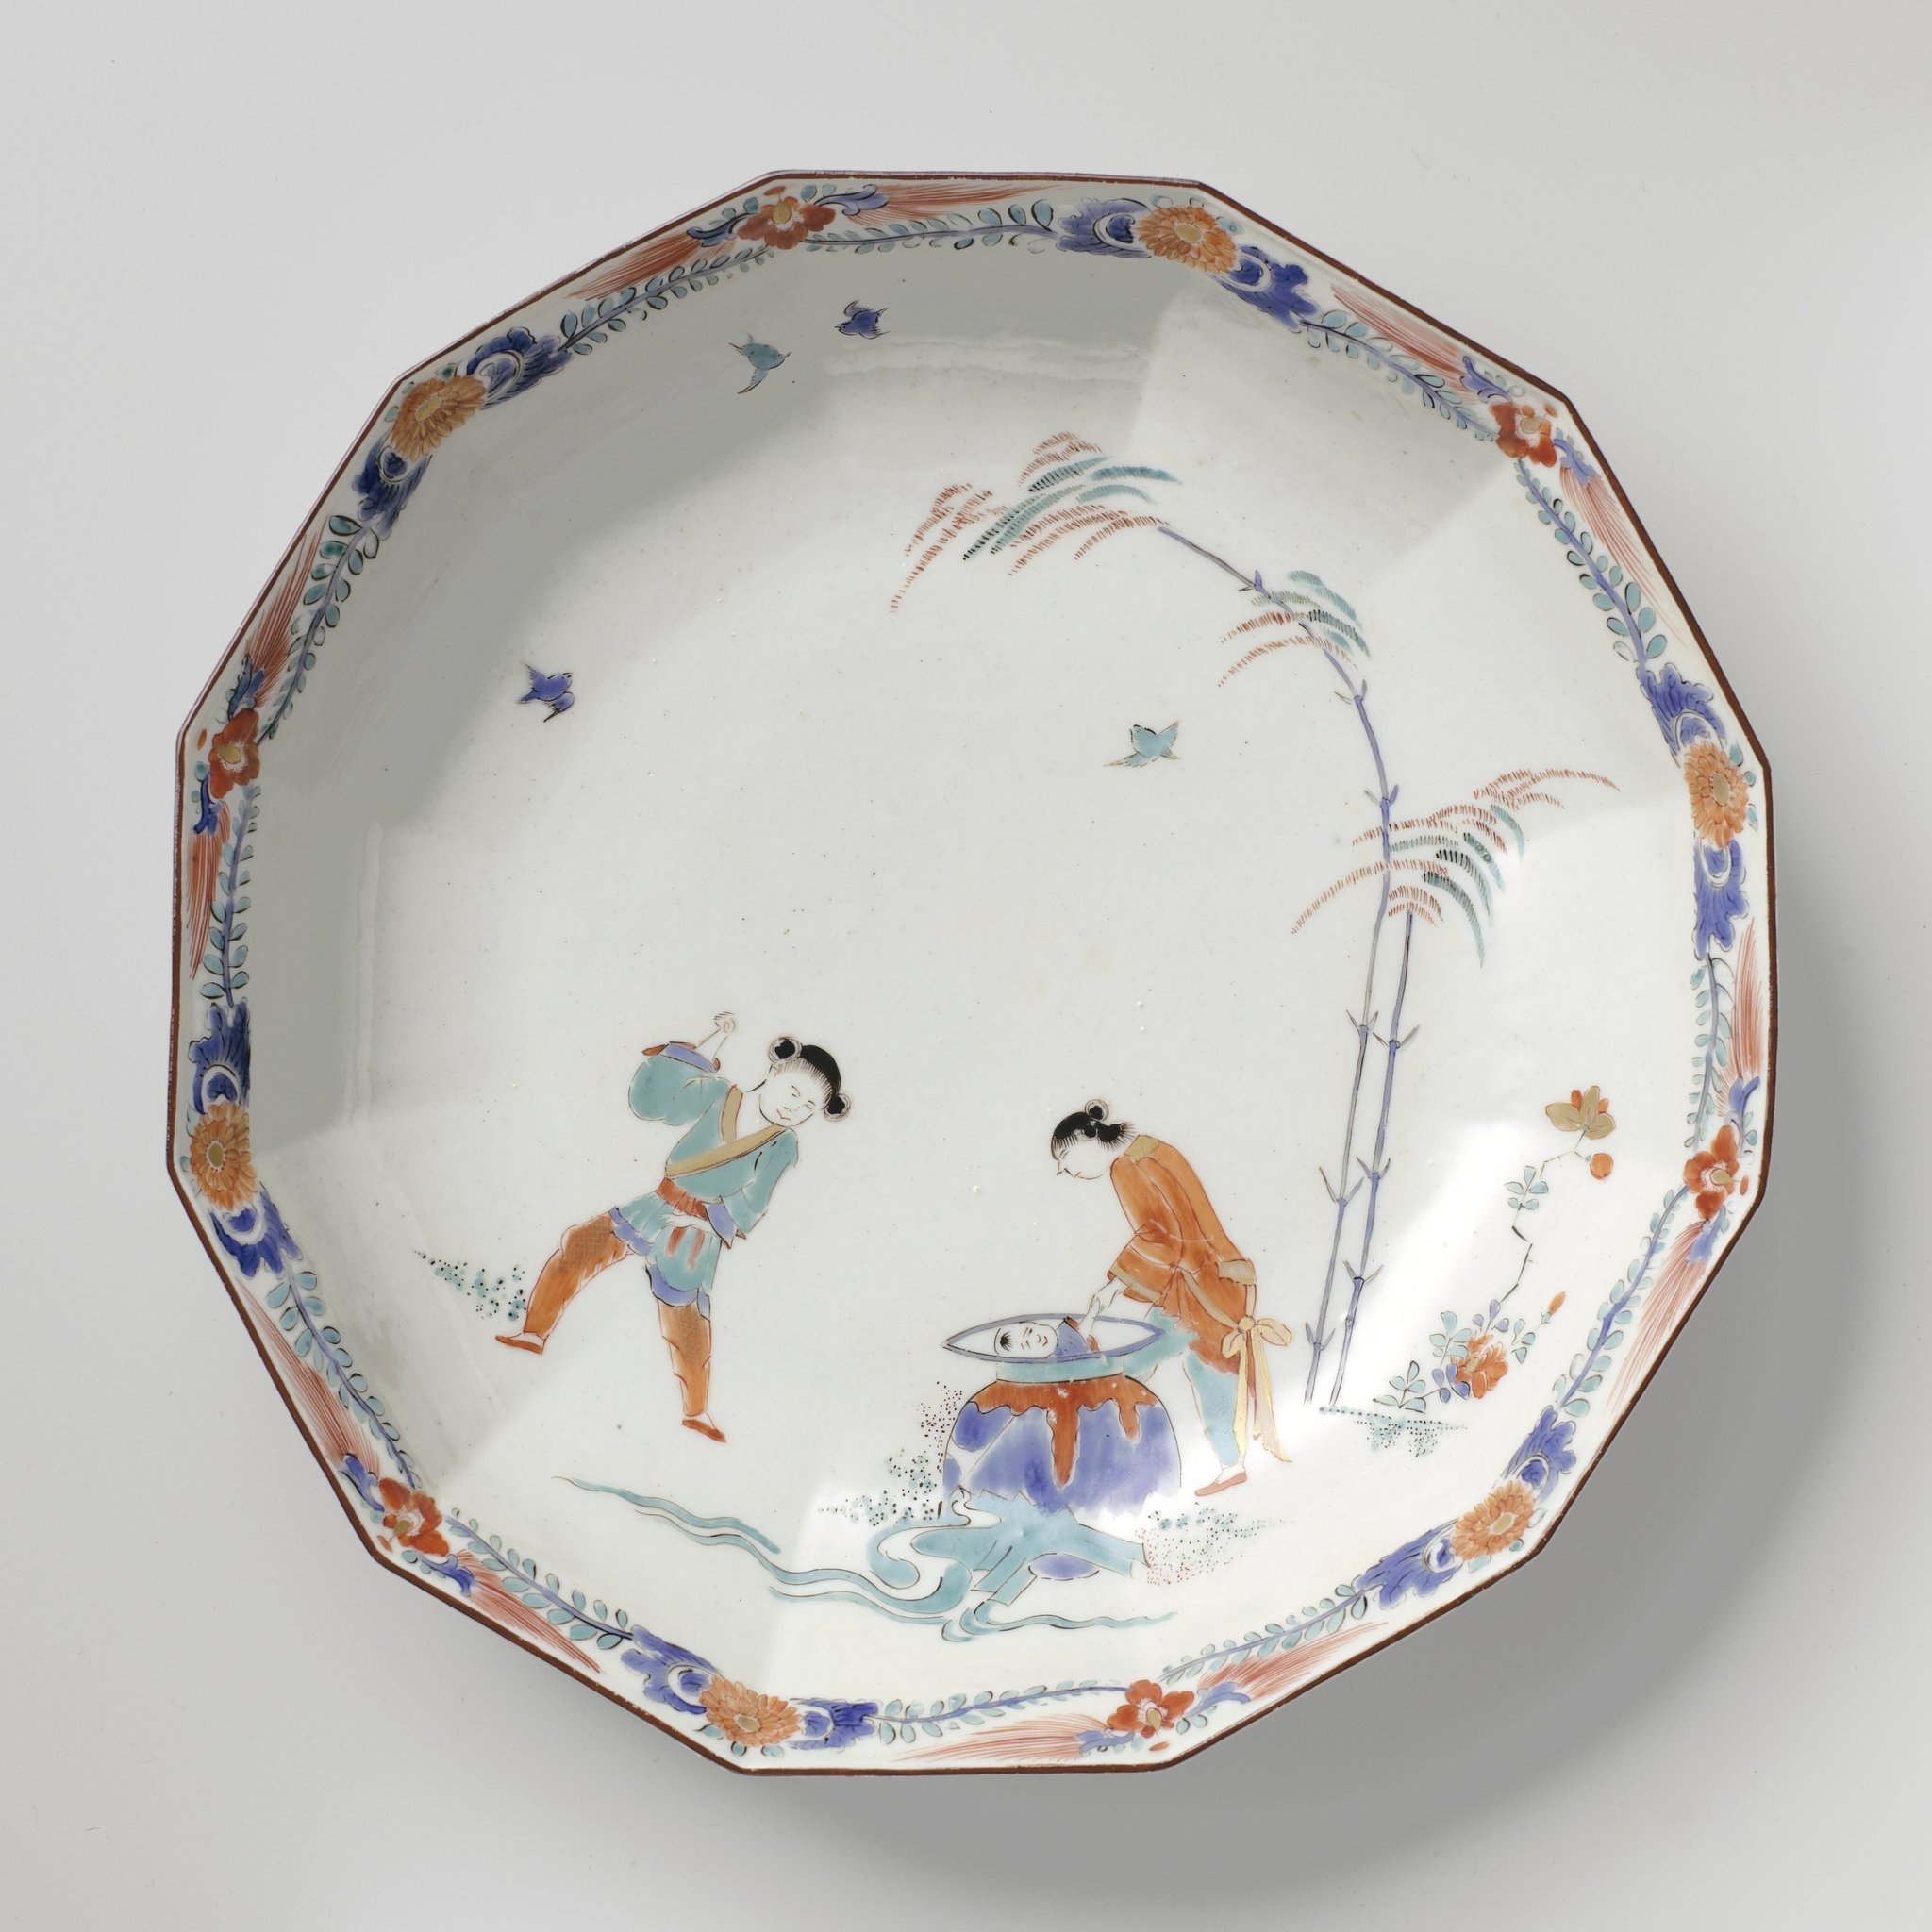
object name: eating drinking utensil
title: Schaal, twaalfhoekig, veelkleurig beschilderd met een Kakiemon-decor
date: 1730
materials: porcelain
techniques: painted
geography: meissen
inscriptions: factory mark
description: Schaal van beschilderd porselein. De schaal is twaalfhoekig en is beschilderd met een Kakiemon-decor; het Shiba Onkô-motief op de spiegel en symmetrische bloemtakken op de rand. De schaal is gemerkt.